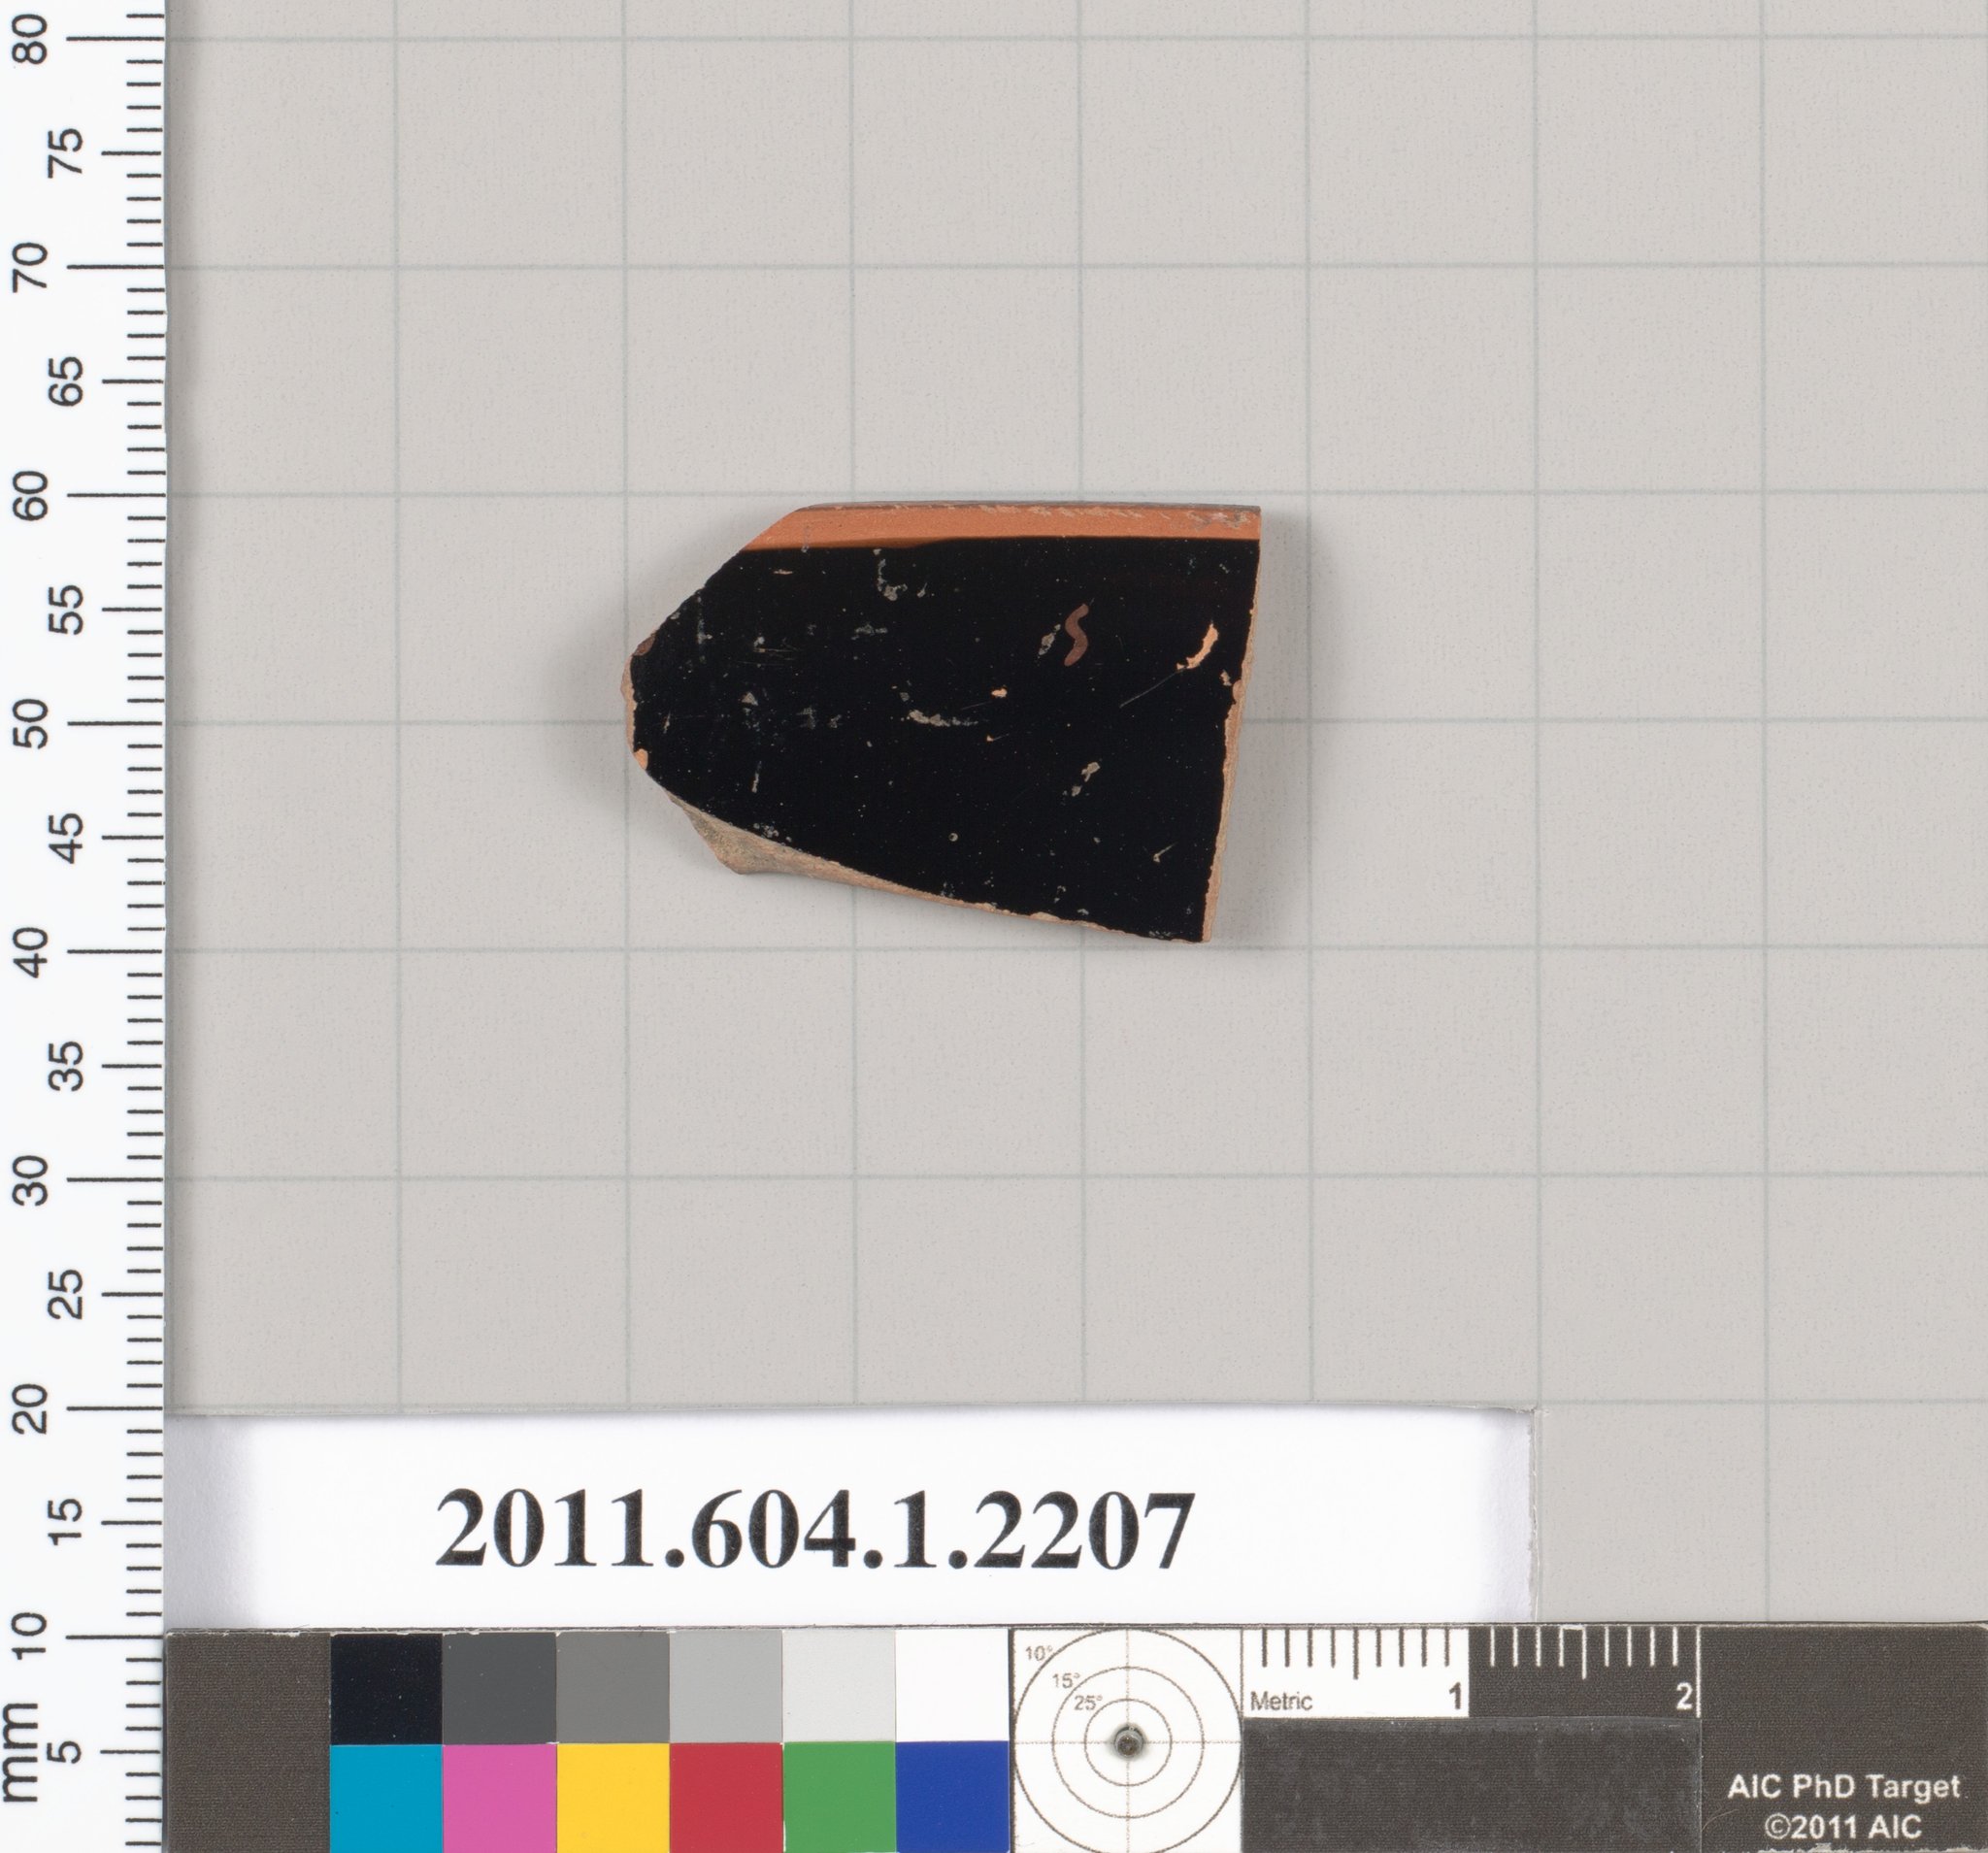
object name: kylix fragment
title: Terracotta rim fragment of a kylix (drinking cup)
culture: greek, attic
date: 500-451 BCE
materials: terracotta